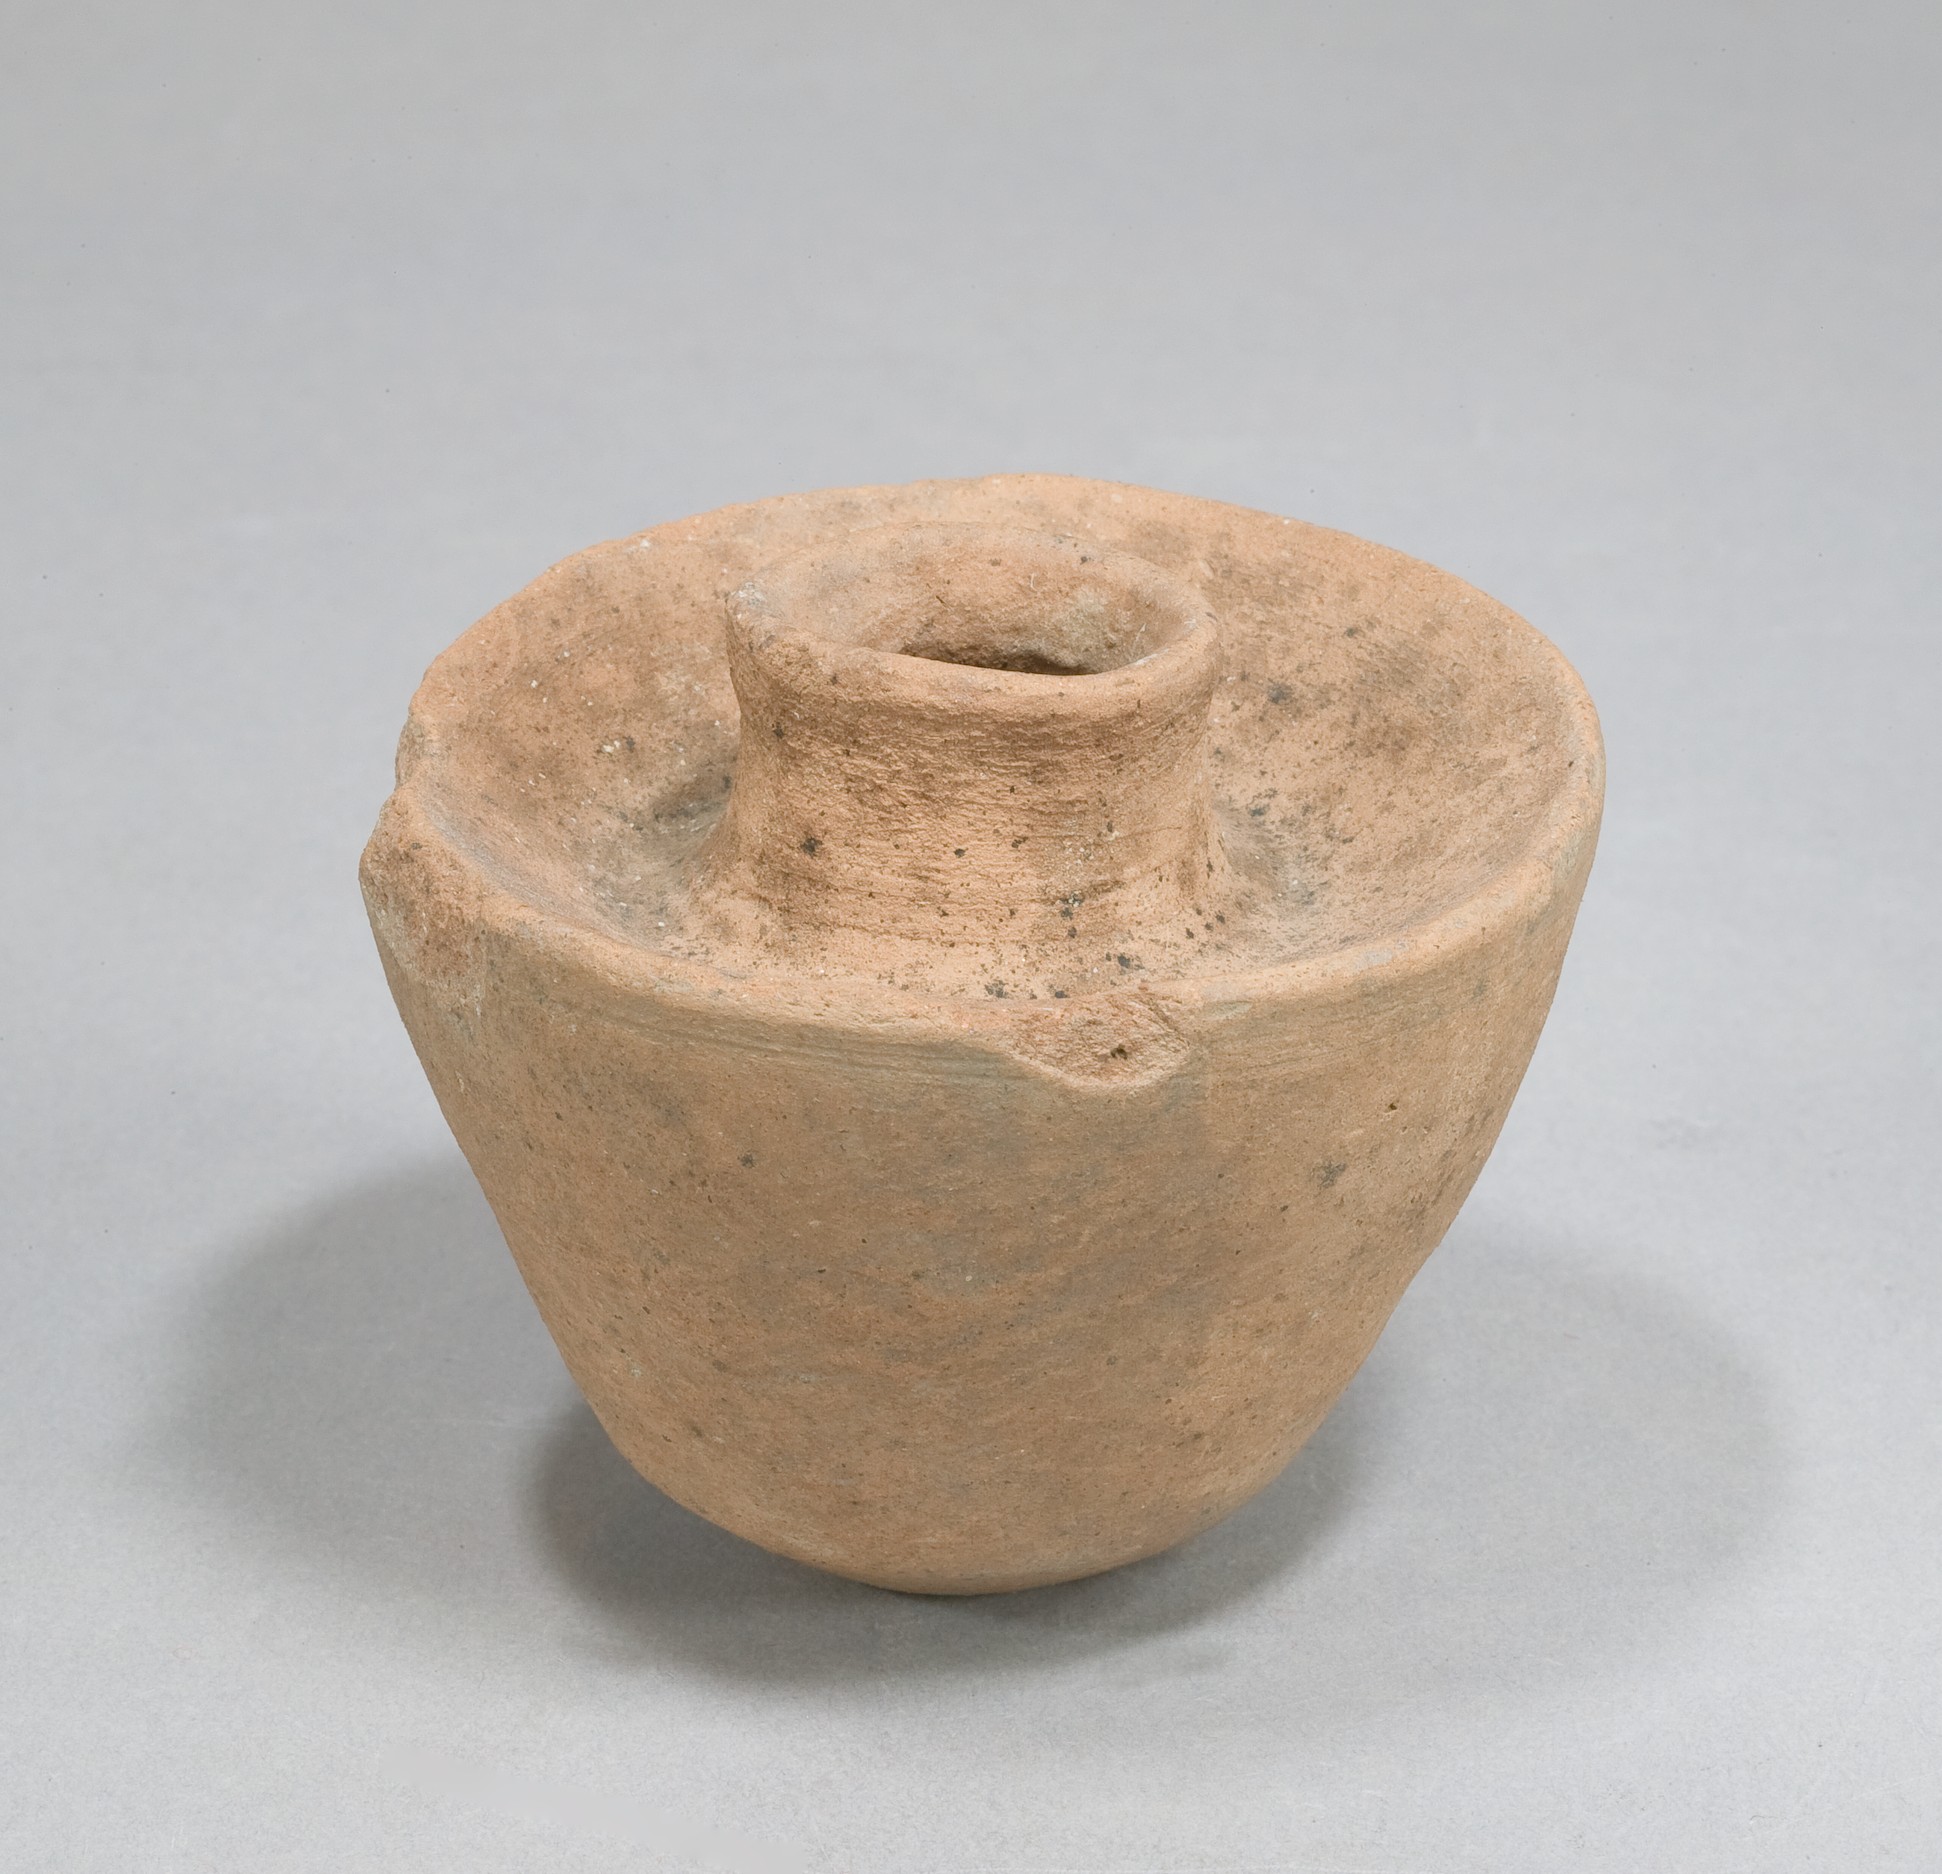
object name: lamp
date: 1981-1640 BCE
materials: pottery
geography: egypt